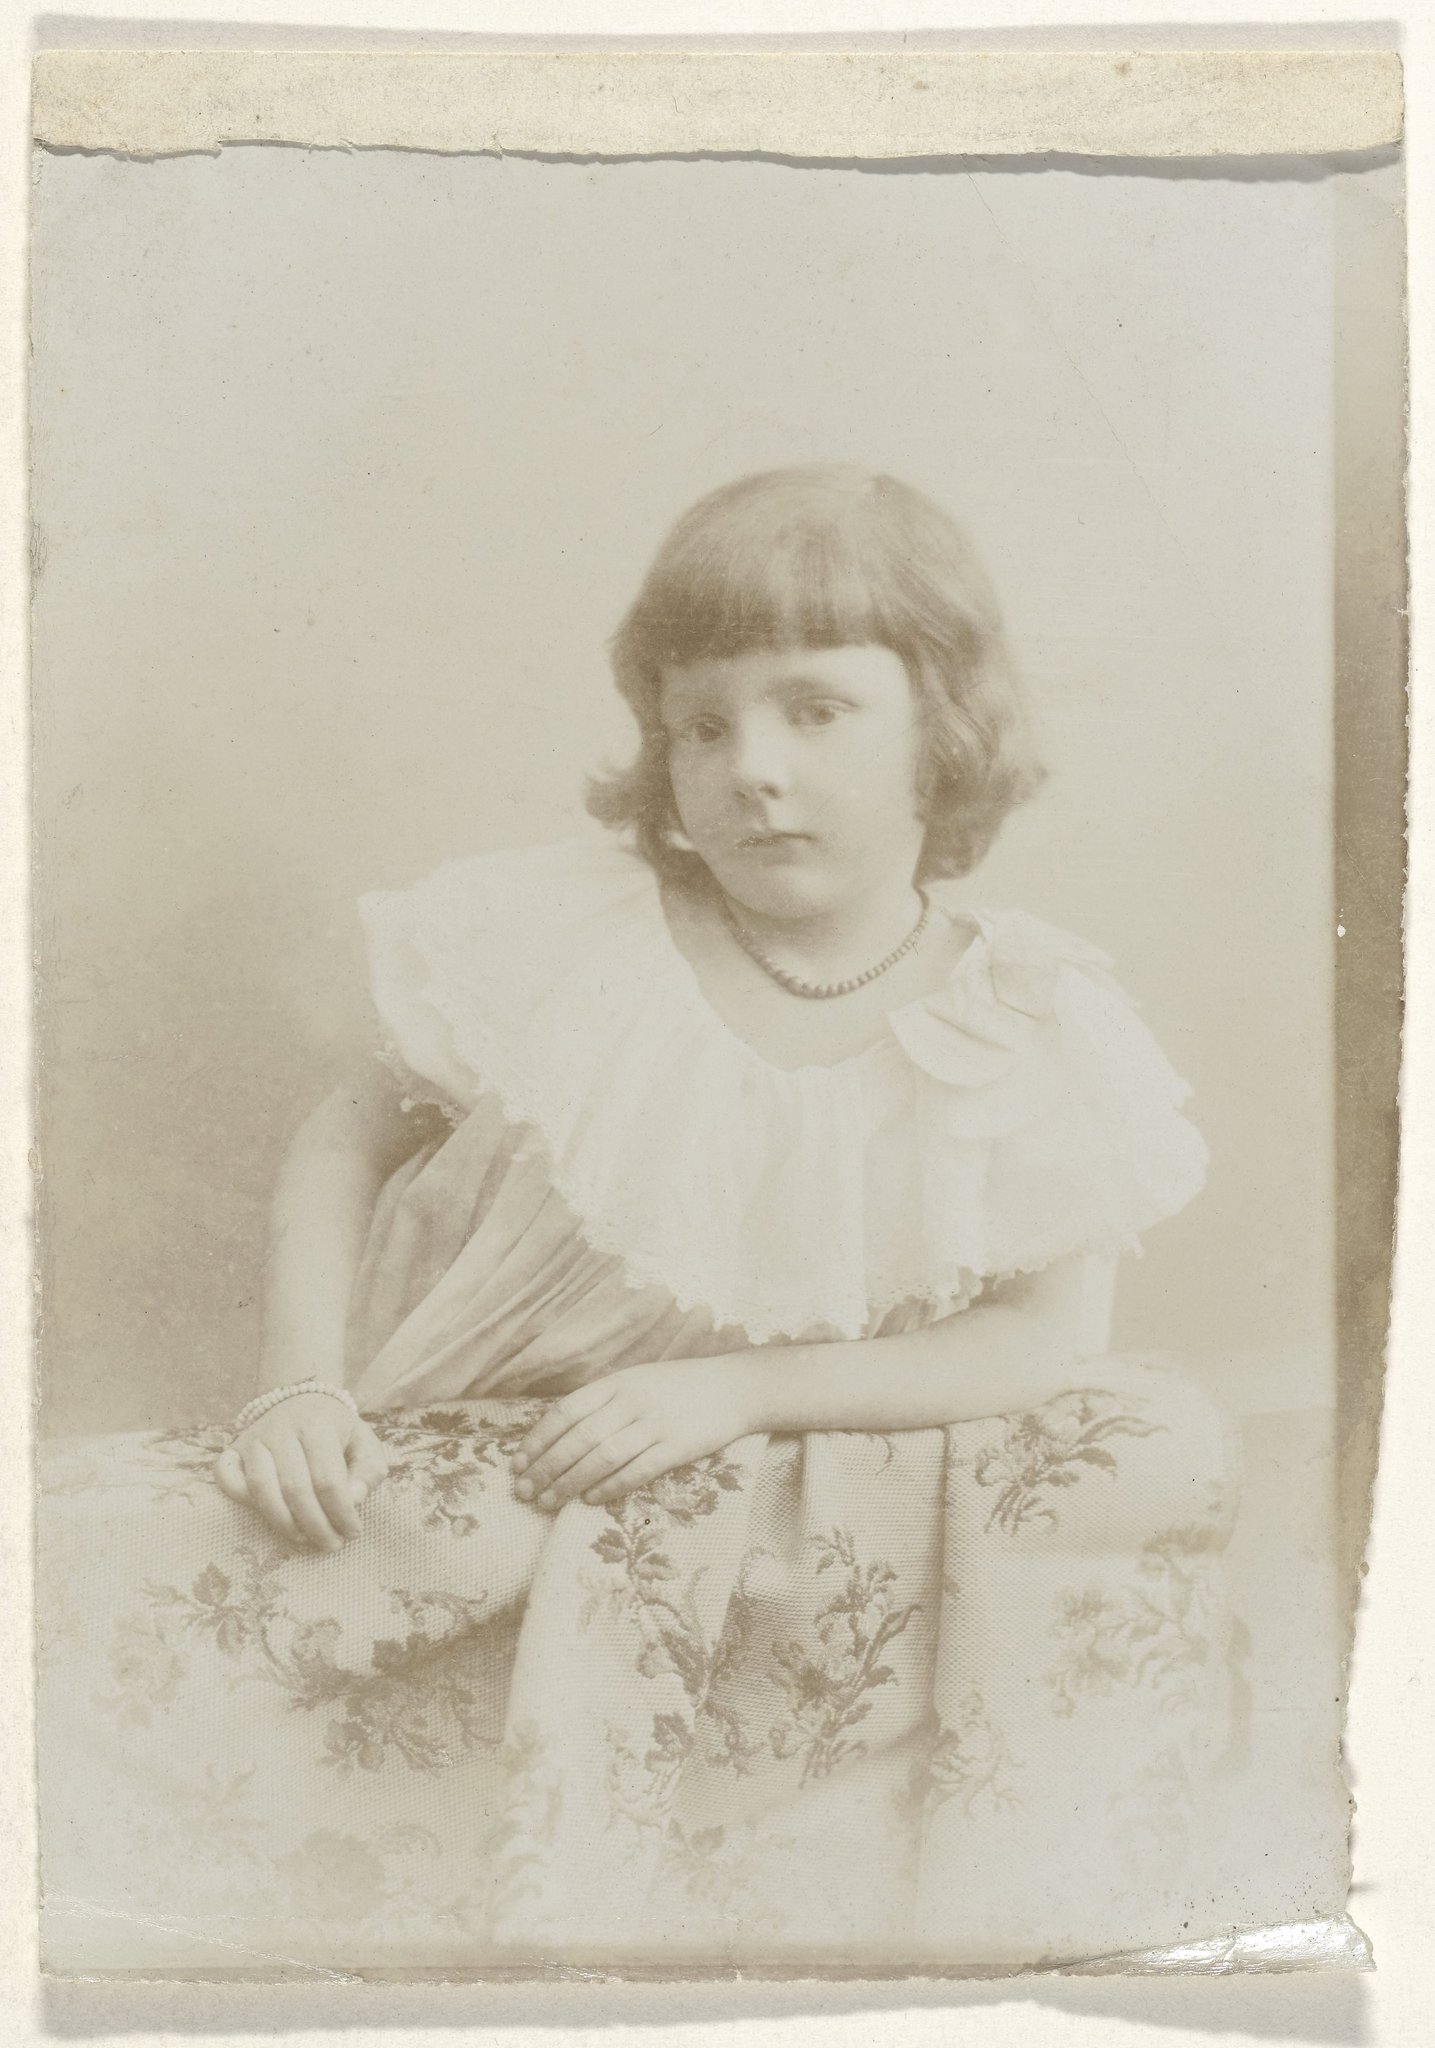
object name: cabinet photograph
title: Portret van Cornelia Vermeulen als kind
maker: Anonymous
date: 1880-1920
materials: photographic support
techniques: albumen print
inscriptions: inscription: ‘Cornelia Vermeulen 3 jaar’